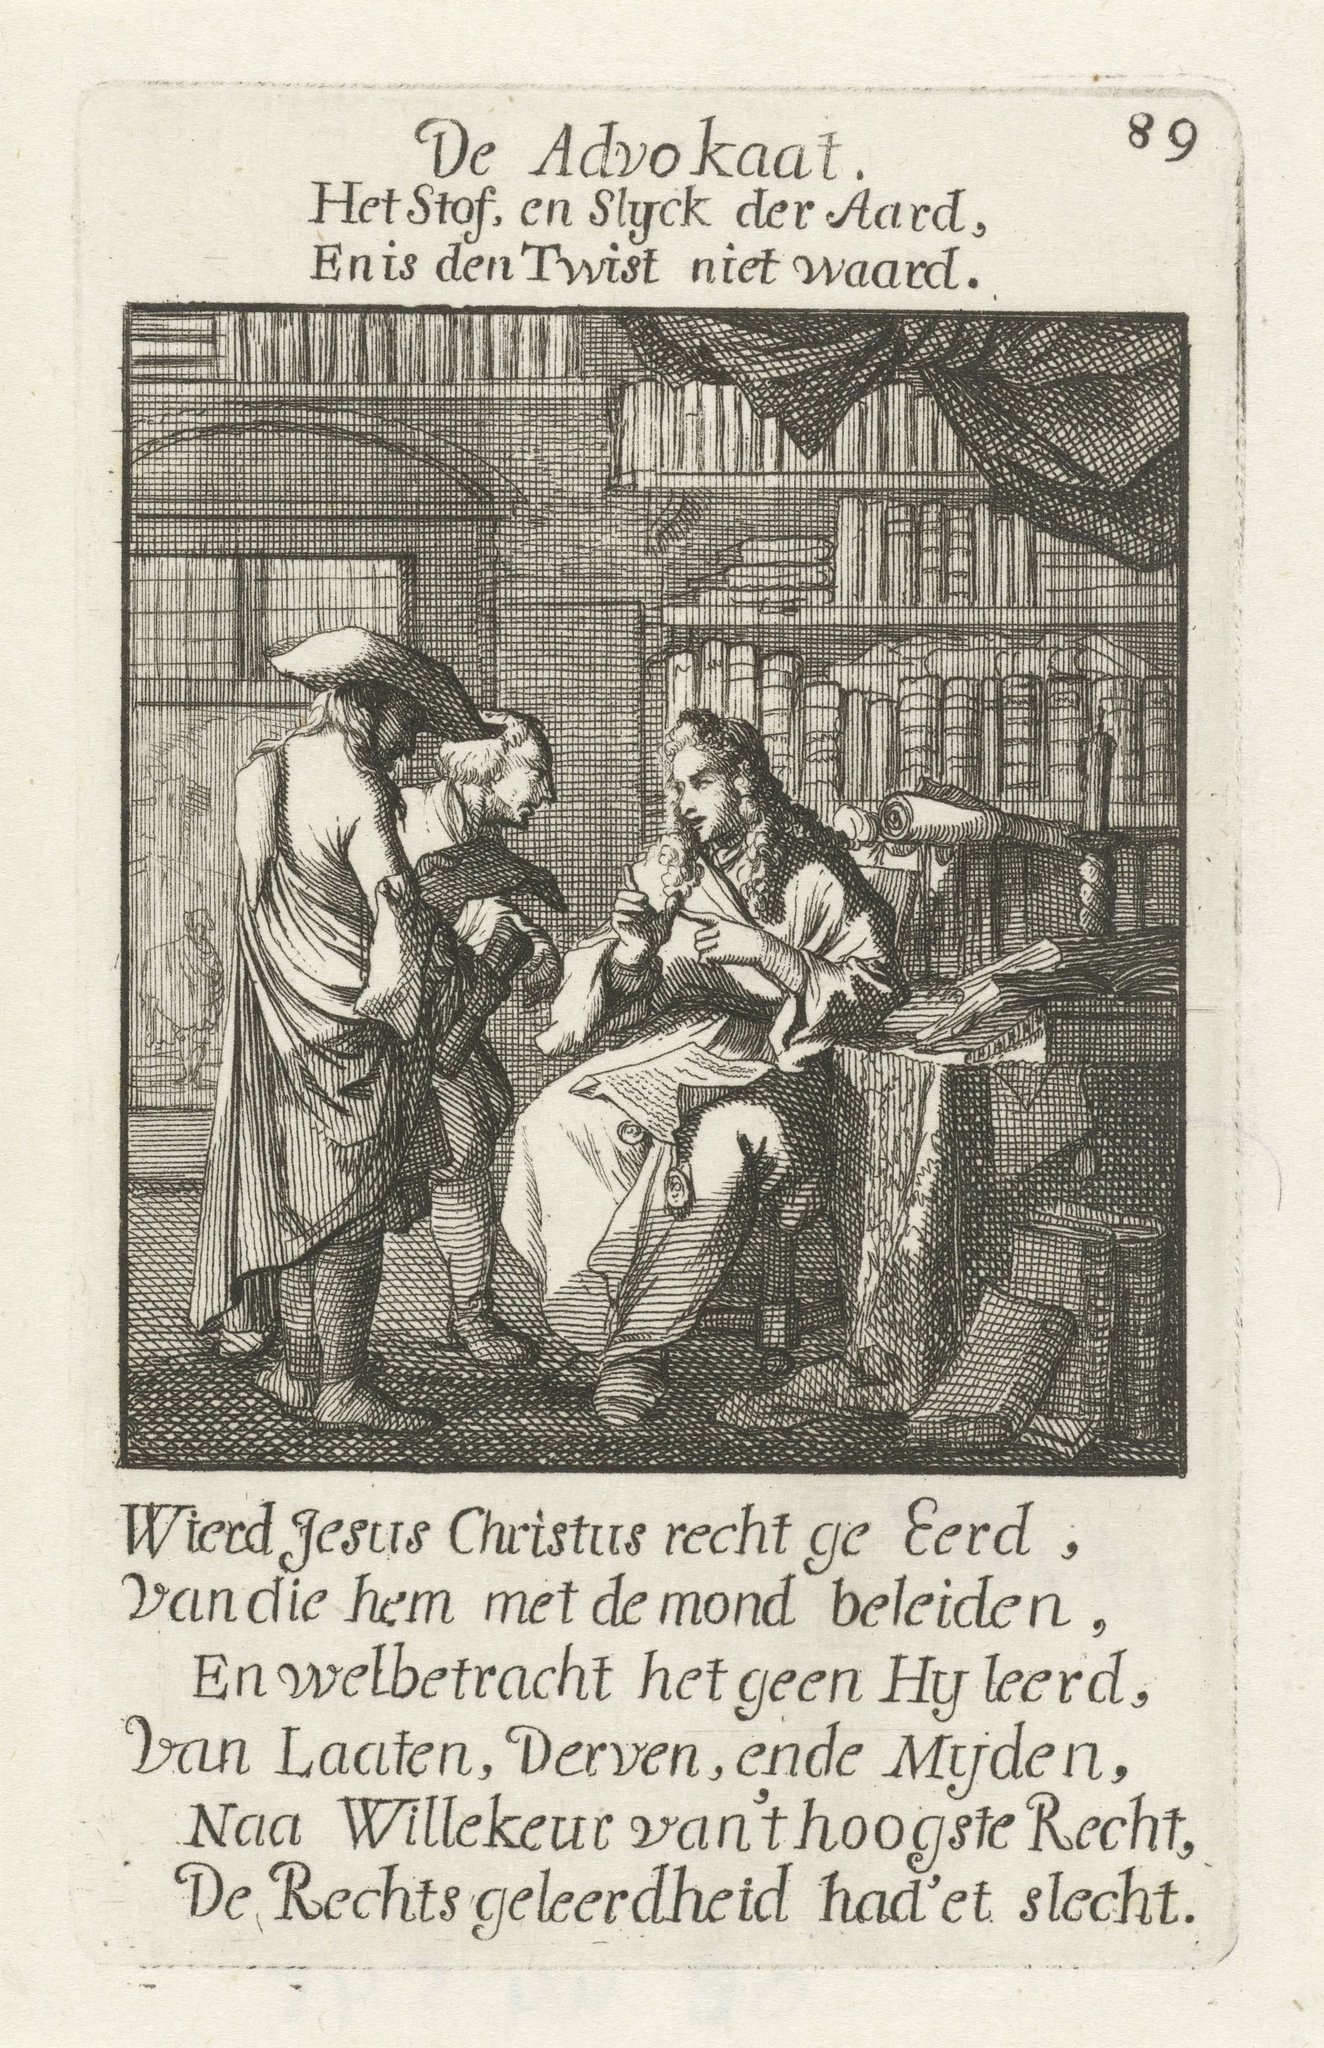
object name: print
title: De Advokaat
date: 1694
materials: paper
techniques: etching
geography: amsterdam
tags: lawyer, attorney at law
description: Maakt deel uit van de 100-delige serie beroepsprenten van Jan en Caspar Luyken, getiteld: Het menselyk bedryf. S.l.s.n., 1694 (eerste druk).